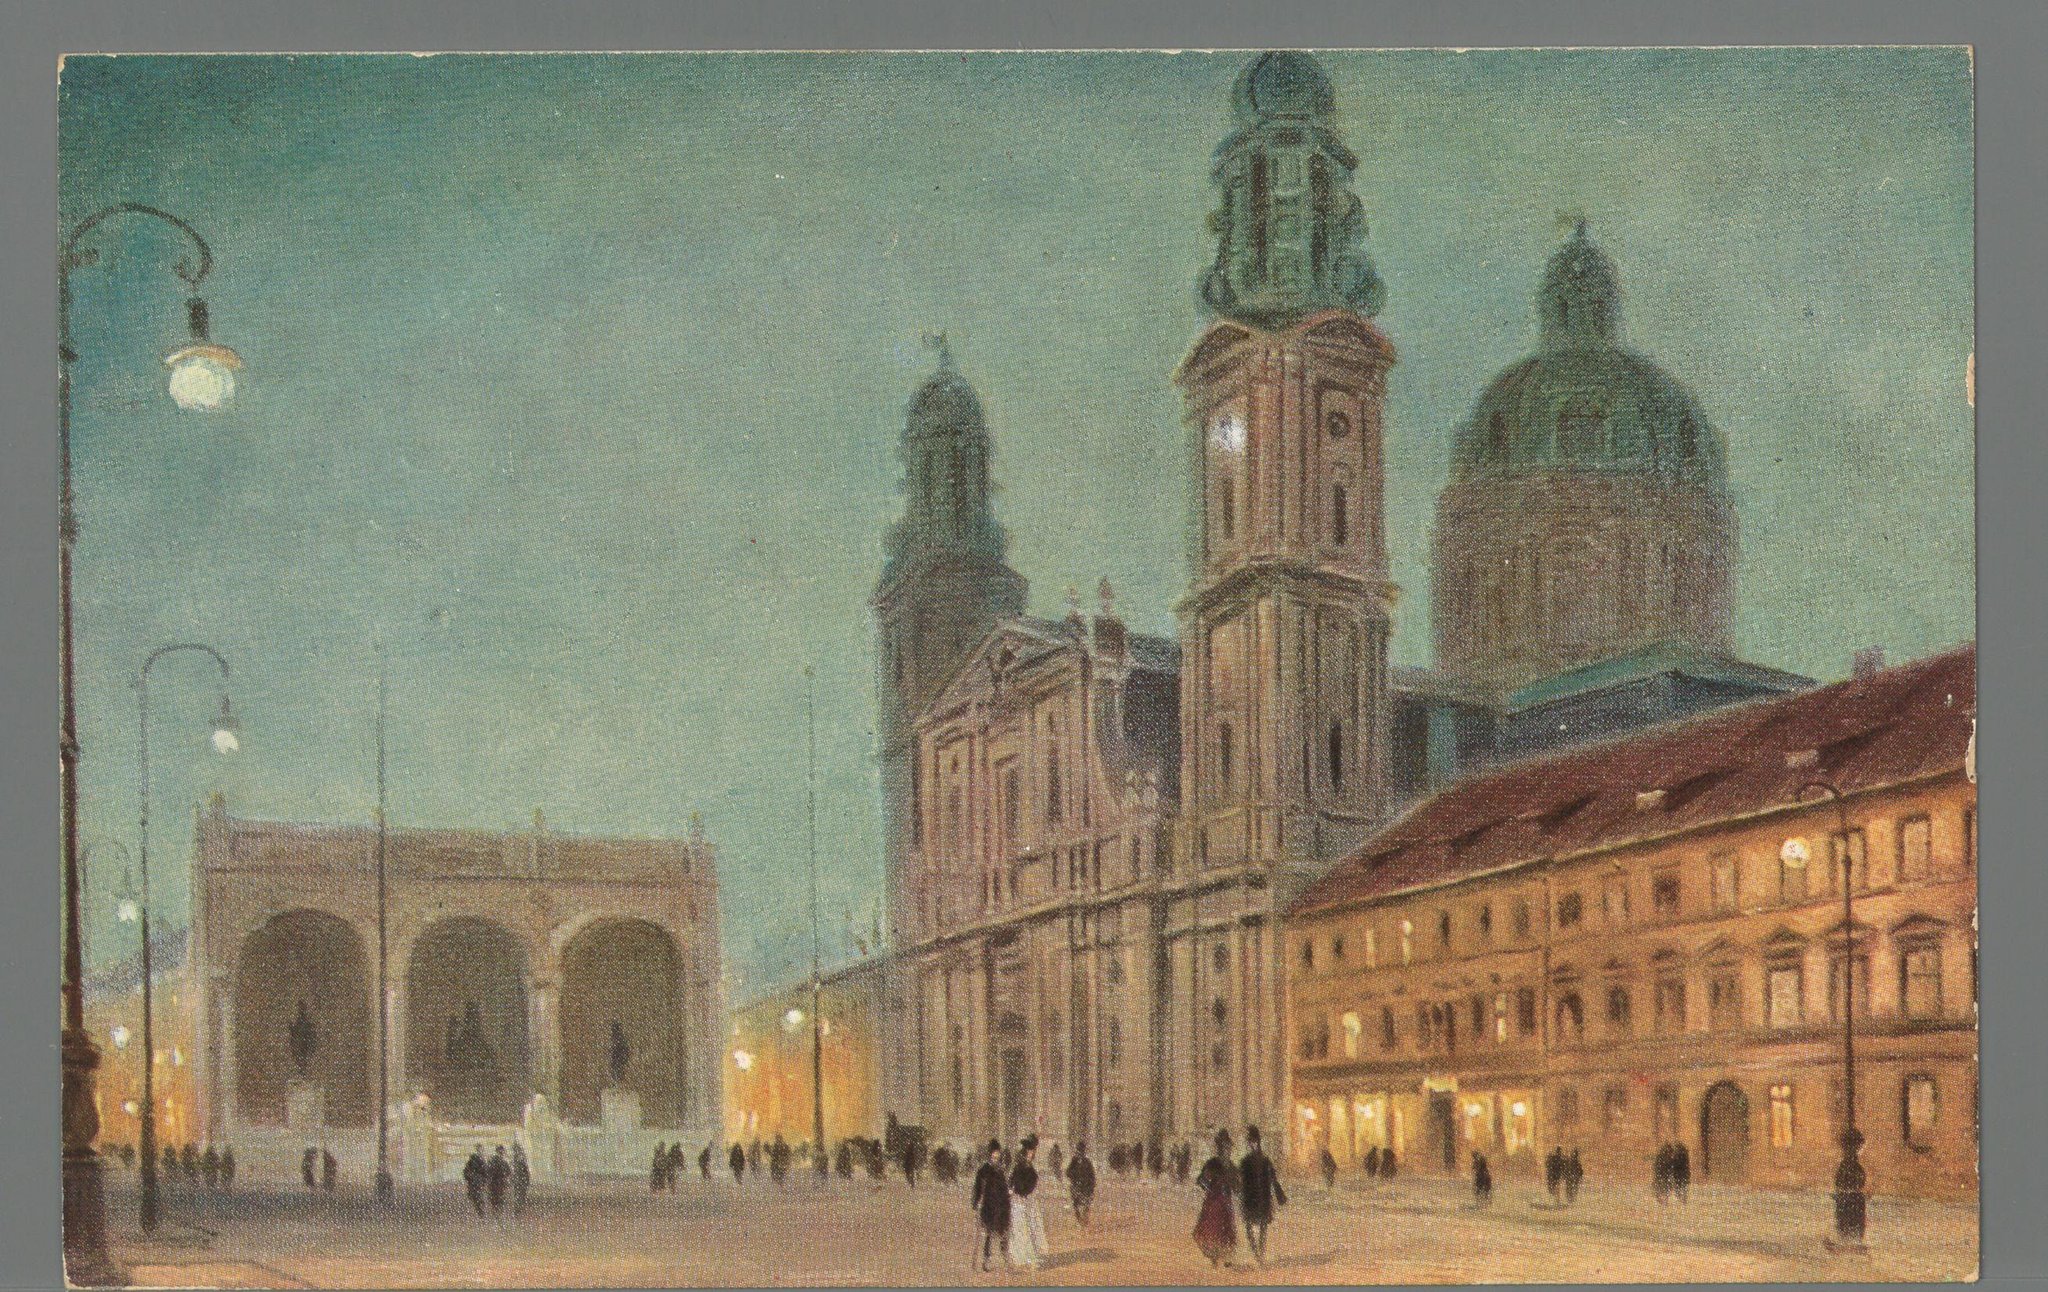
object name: reproduction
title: München: Theatinerkirche und Feldherrnhalle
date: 1905-1909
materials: cardboard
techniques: writing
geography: nuremberg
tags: church (exterior), loggia, verandah, porch